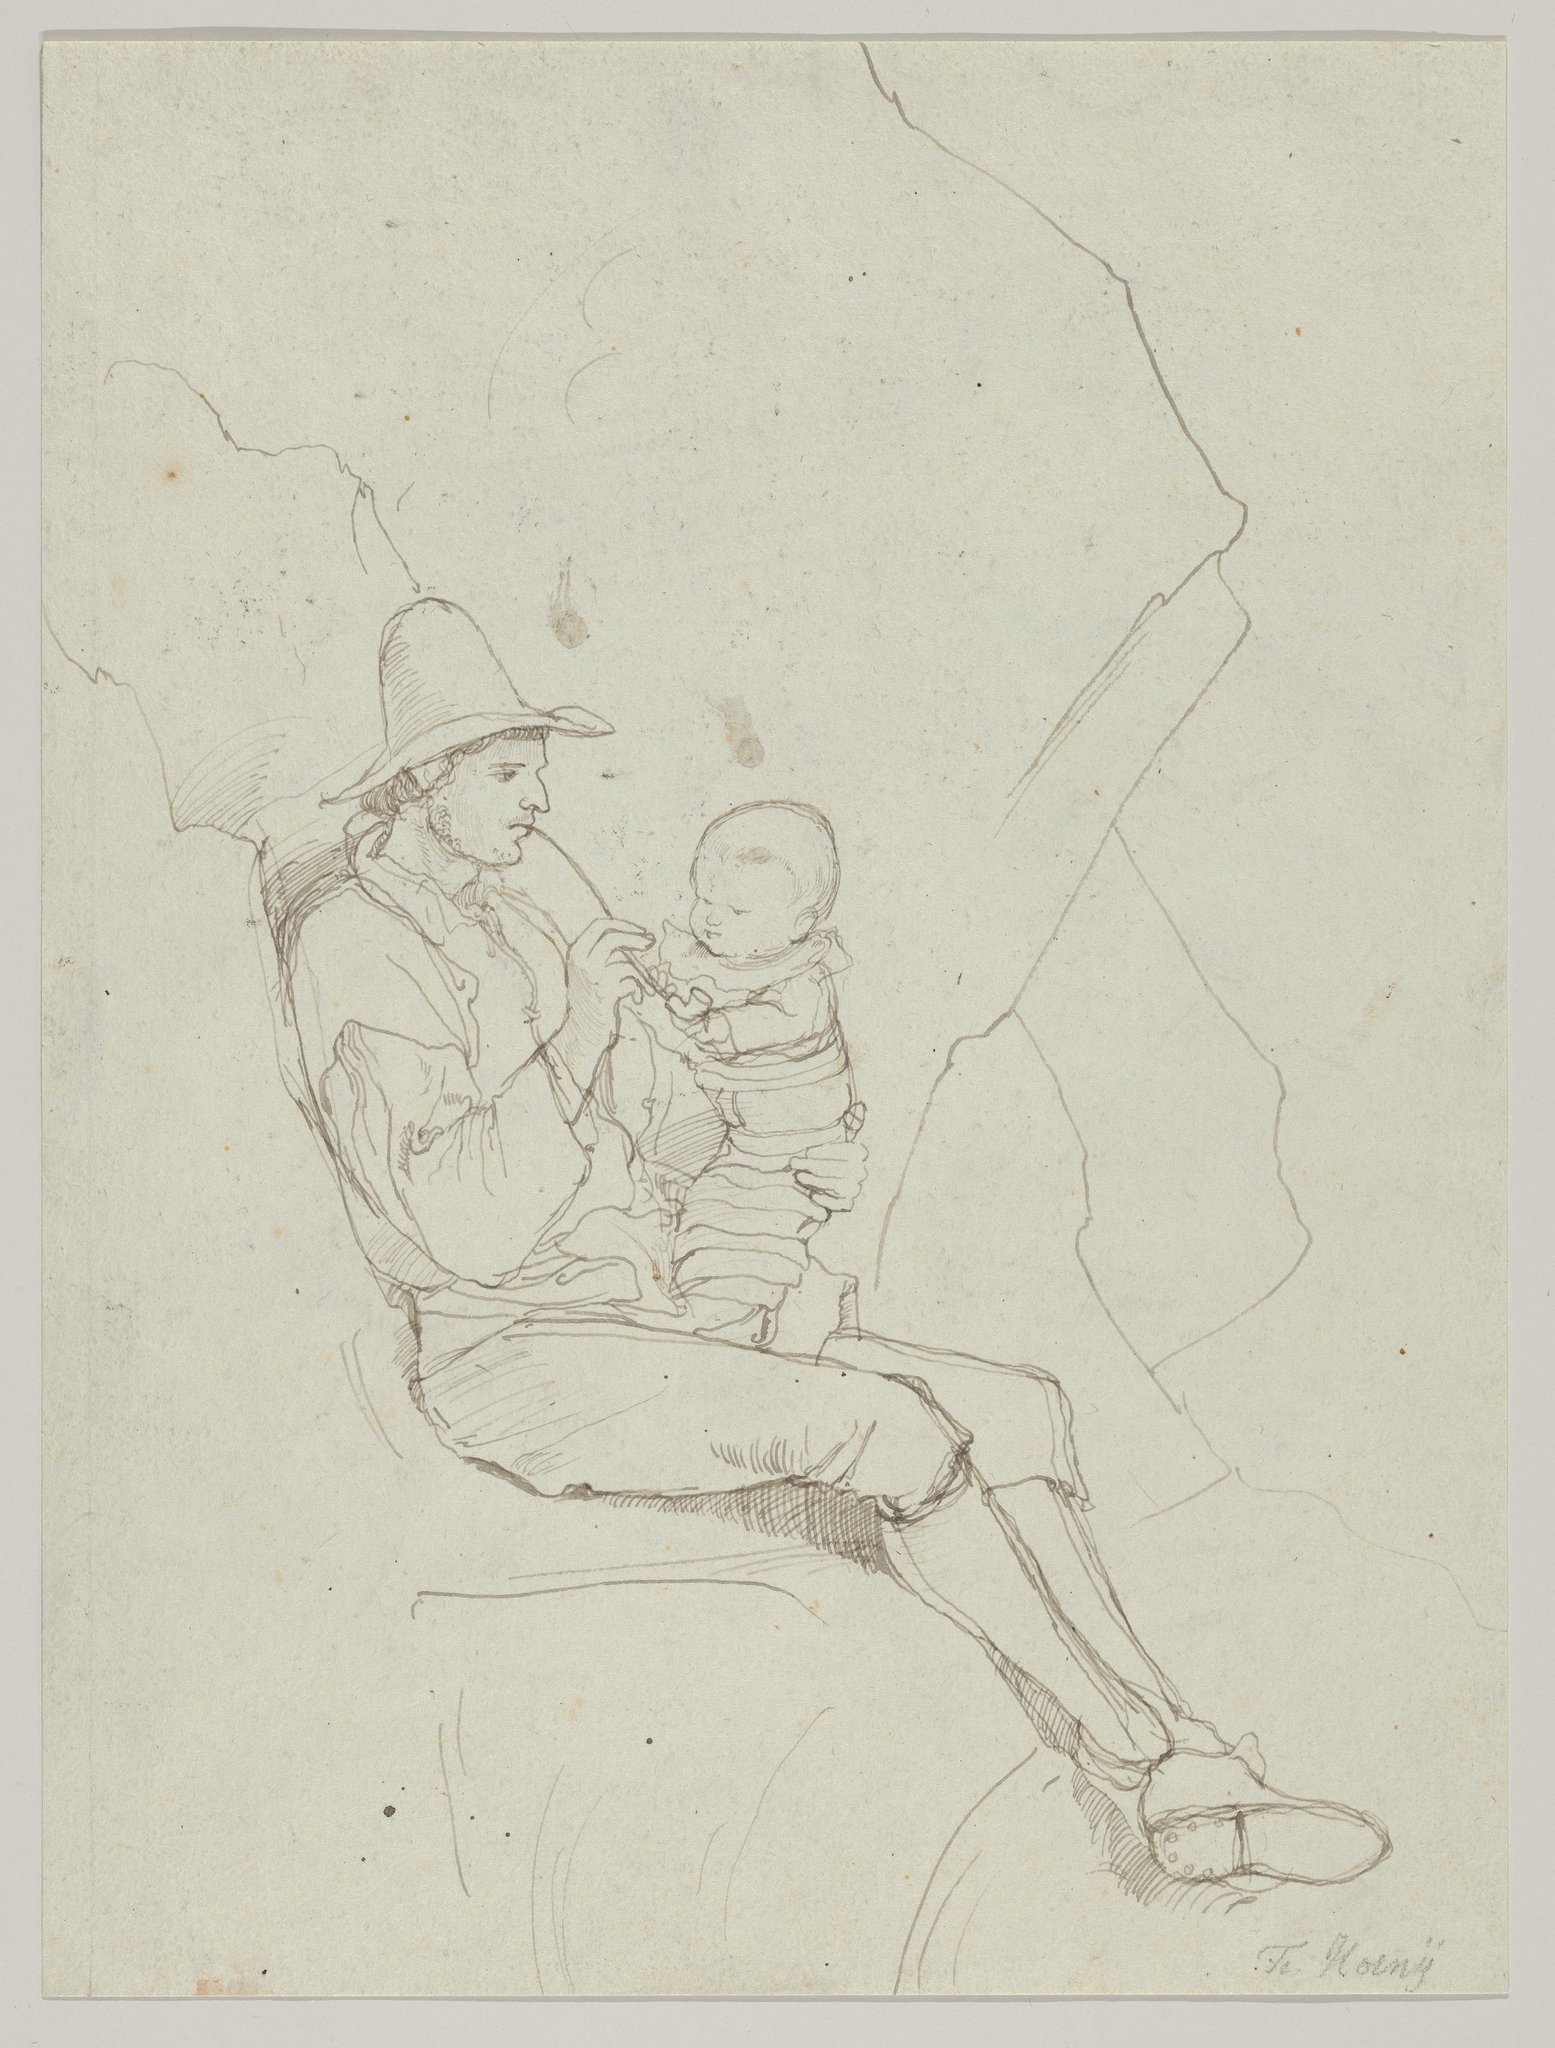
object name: drawing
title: A Seated Italian Shepherd with a Small Child on his lap; verso: A Southern Landscape with a Woman Carrying a Jar on her Head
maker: franz theobald horny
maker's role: artist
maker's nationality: german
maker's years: 1798-1824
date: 1820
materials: graphite, ink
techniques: pen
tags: children,men